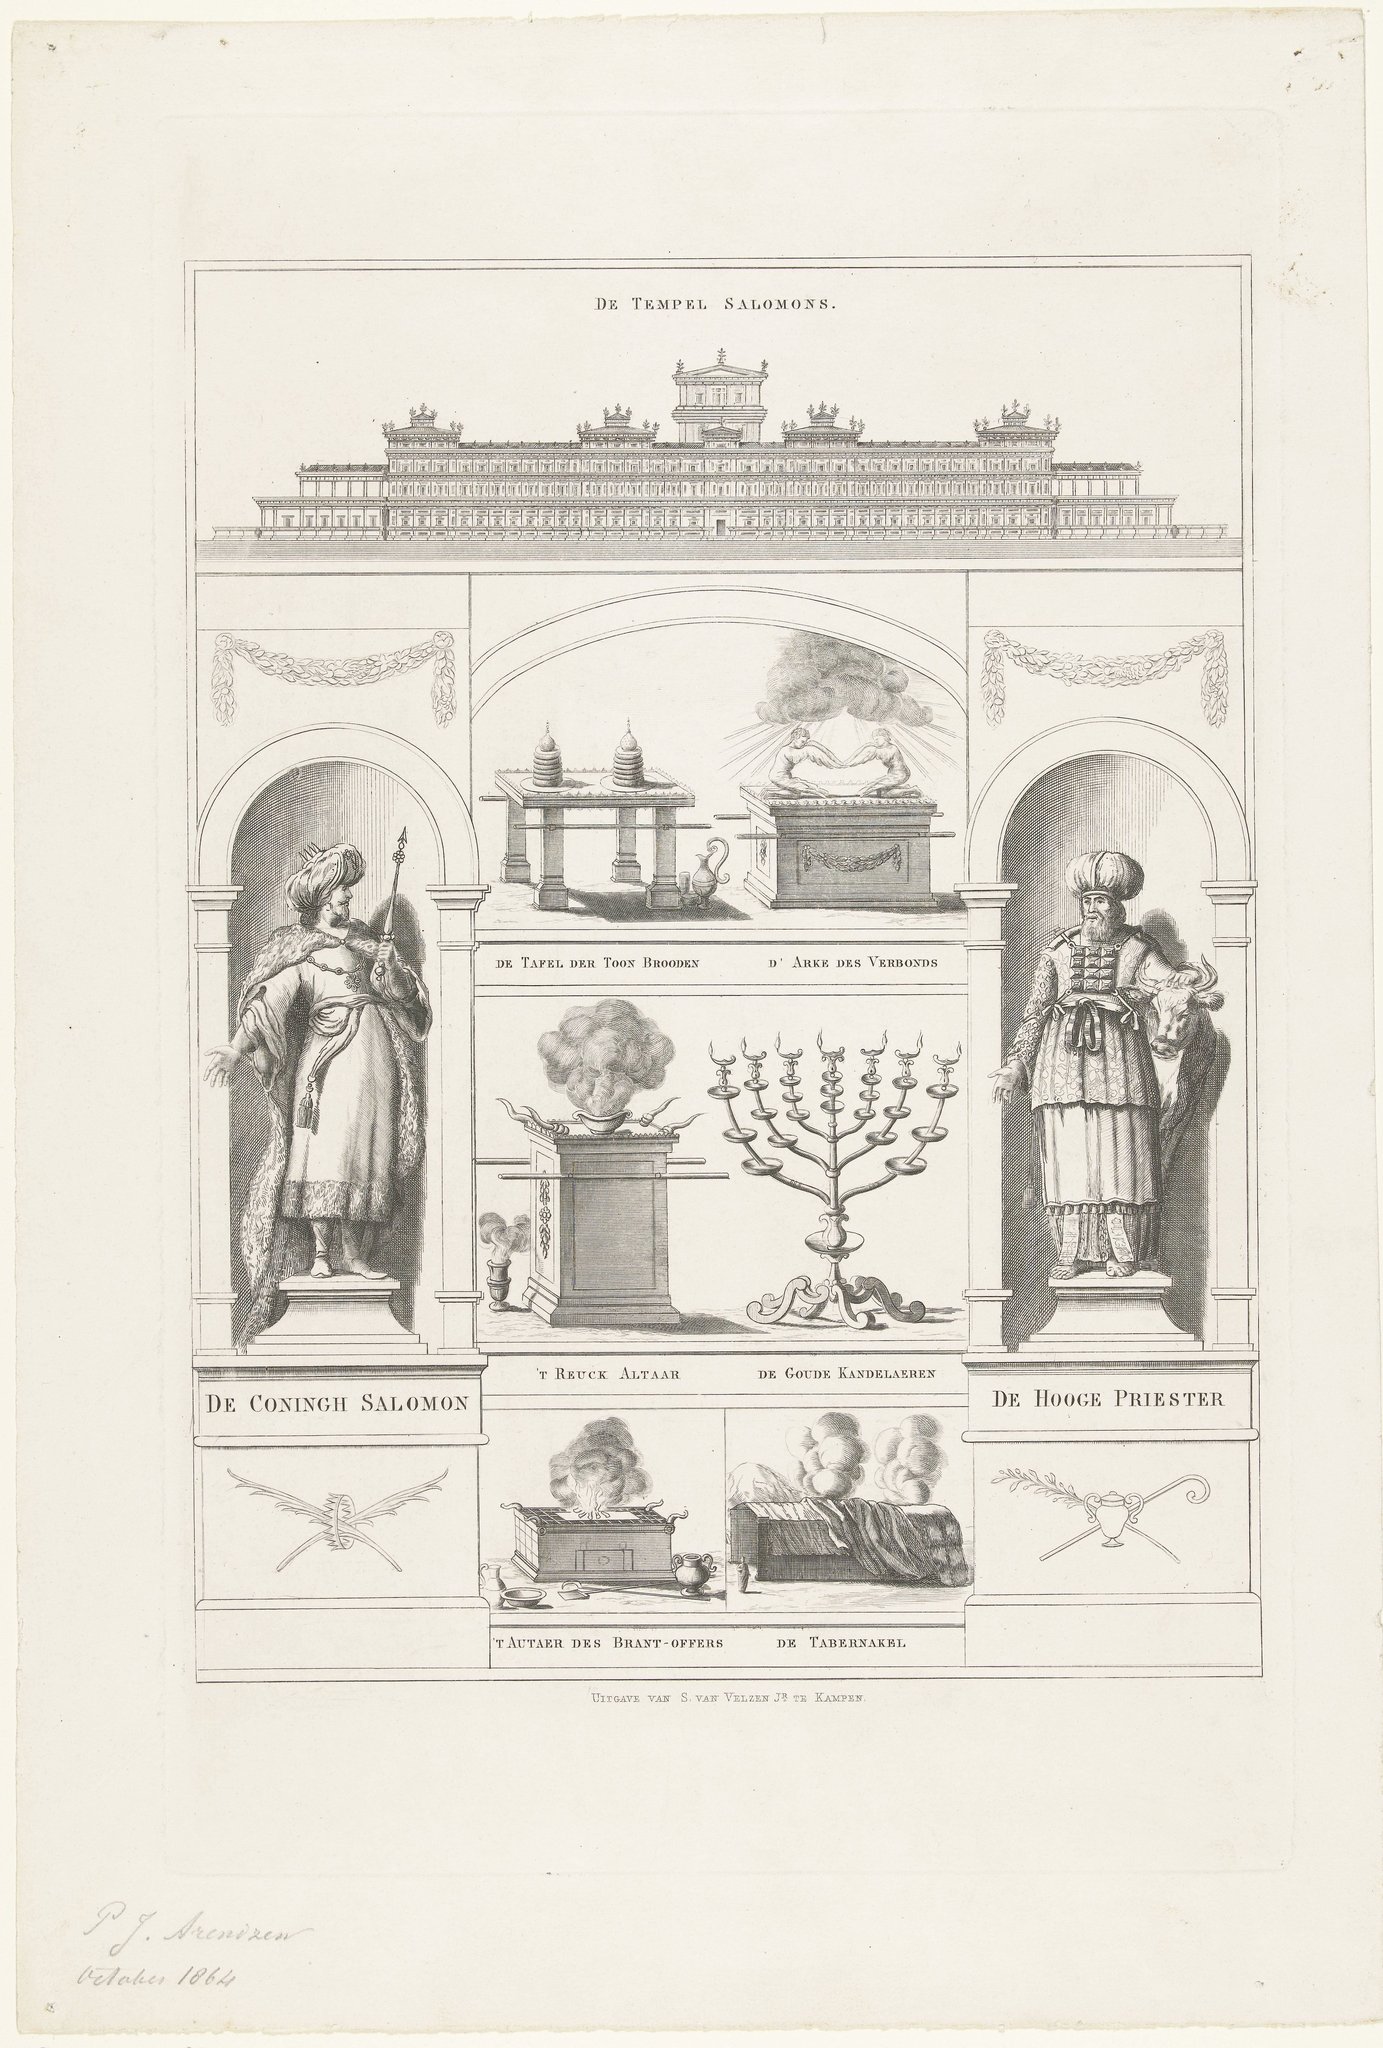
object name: print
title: De tempel Salomons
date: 1864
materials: paper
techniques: engraving, etching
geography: kampen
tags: ark of the covenant ~ jewish religion, tabernacle, 'mishkan' ~ jewish religion, temple of solomon (1 kings 5-9; 2 chronicles 2-7), the seven-branched candlestick ~ temple of solomon, two cherubs placed within the inner sanctuary ~ temple of solomon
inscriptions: inscription: ‘PJ. Arendzen October 1864’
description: De tempel van Salomon, onder het gebouw twee beelden van Koning Salomon en de Hogepriester met een os. In het midden zes objecten uit de tempel: de tafel der toonbroden, de Ark des Verbonds, het reukaltaar, de gouden kandelaar, het altaar van het brandoffer en de tabernakel.